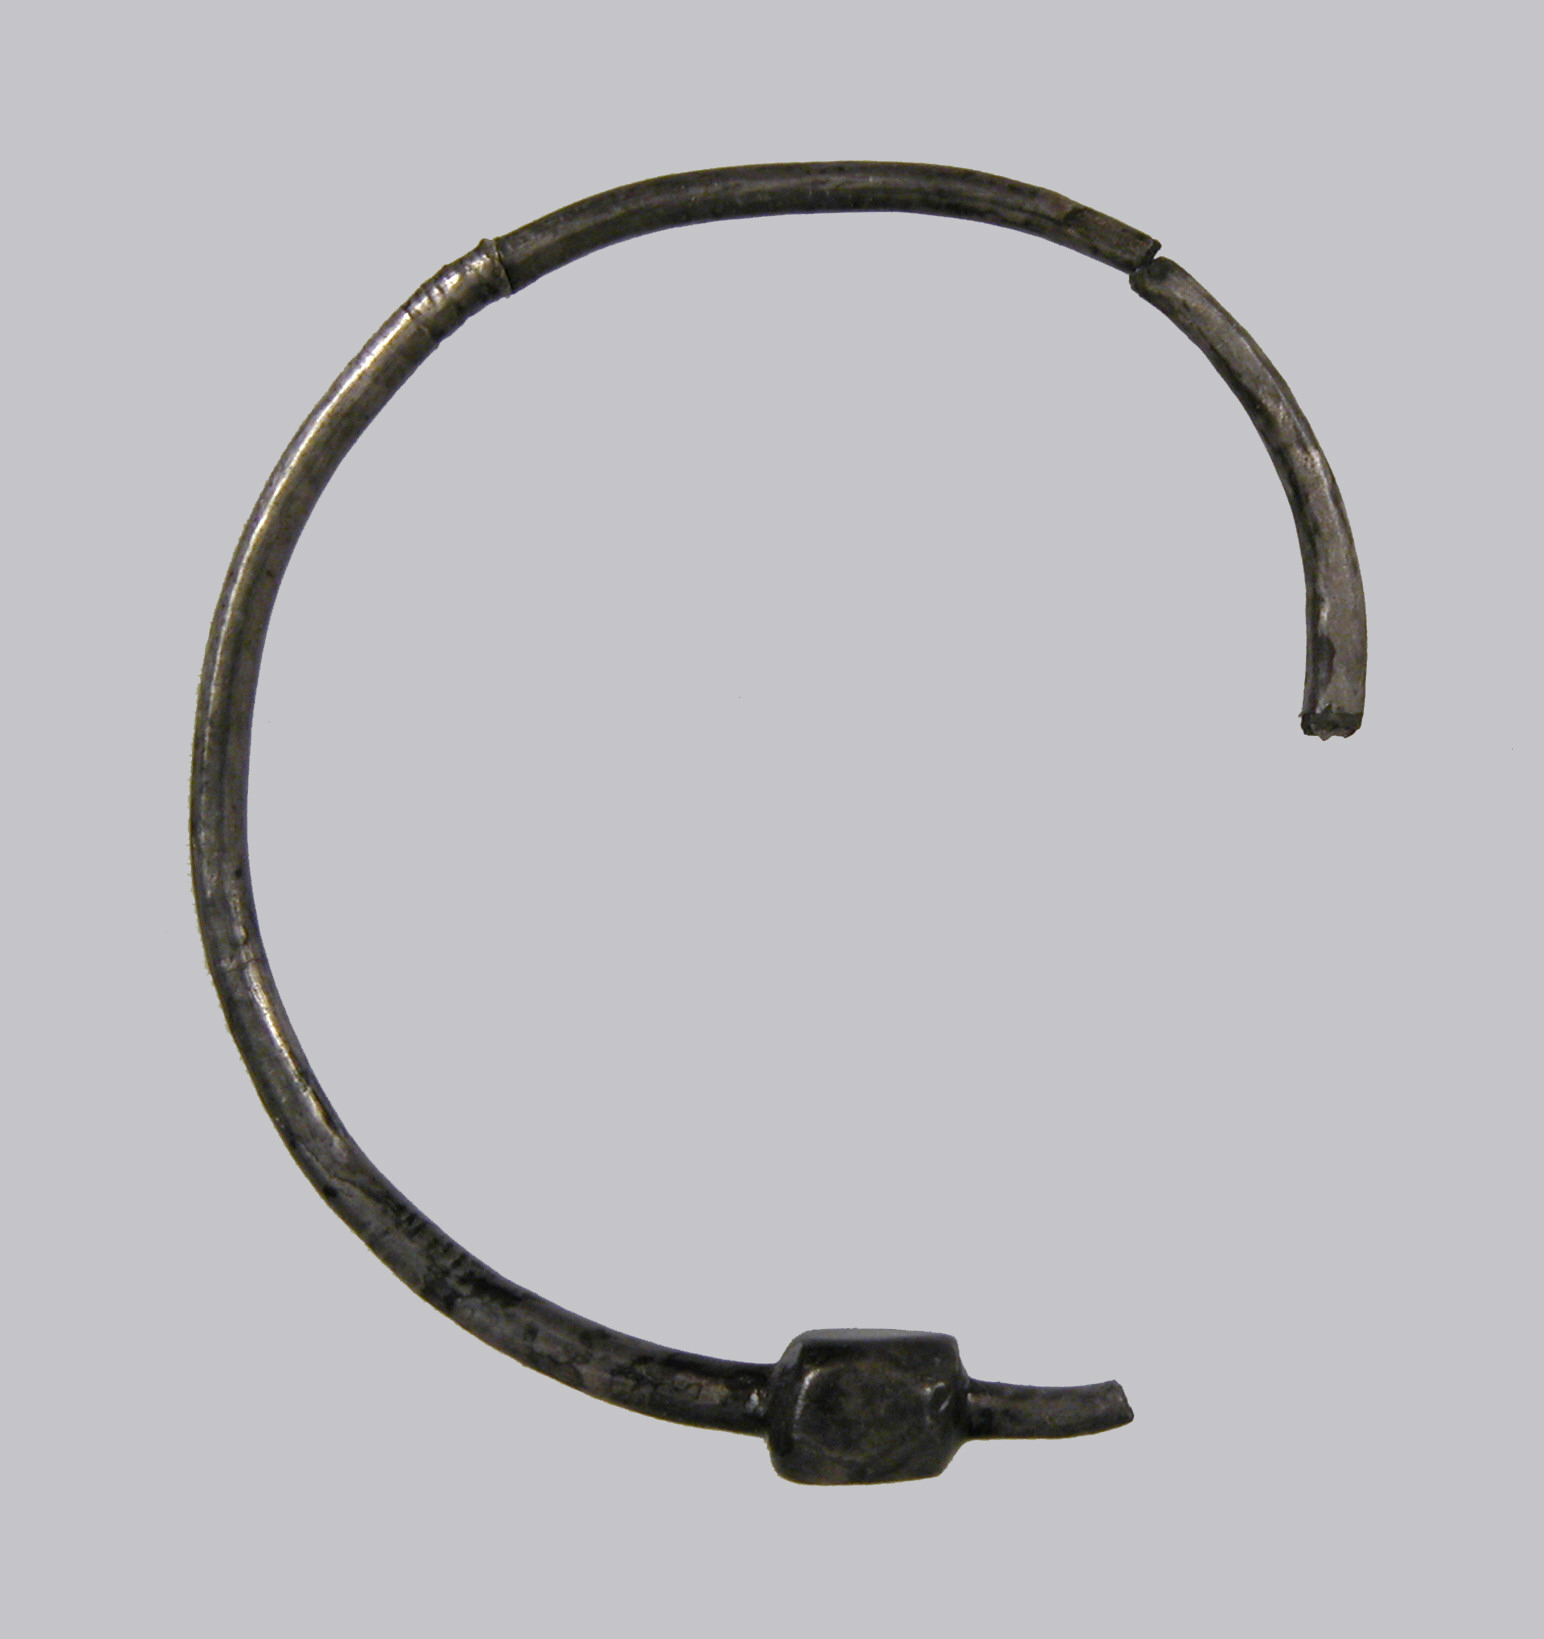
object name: earring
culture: frankish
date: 601-700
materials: silver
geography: germany